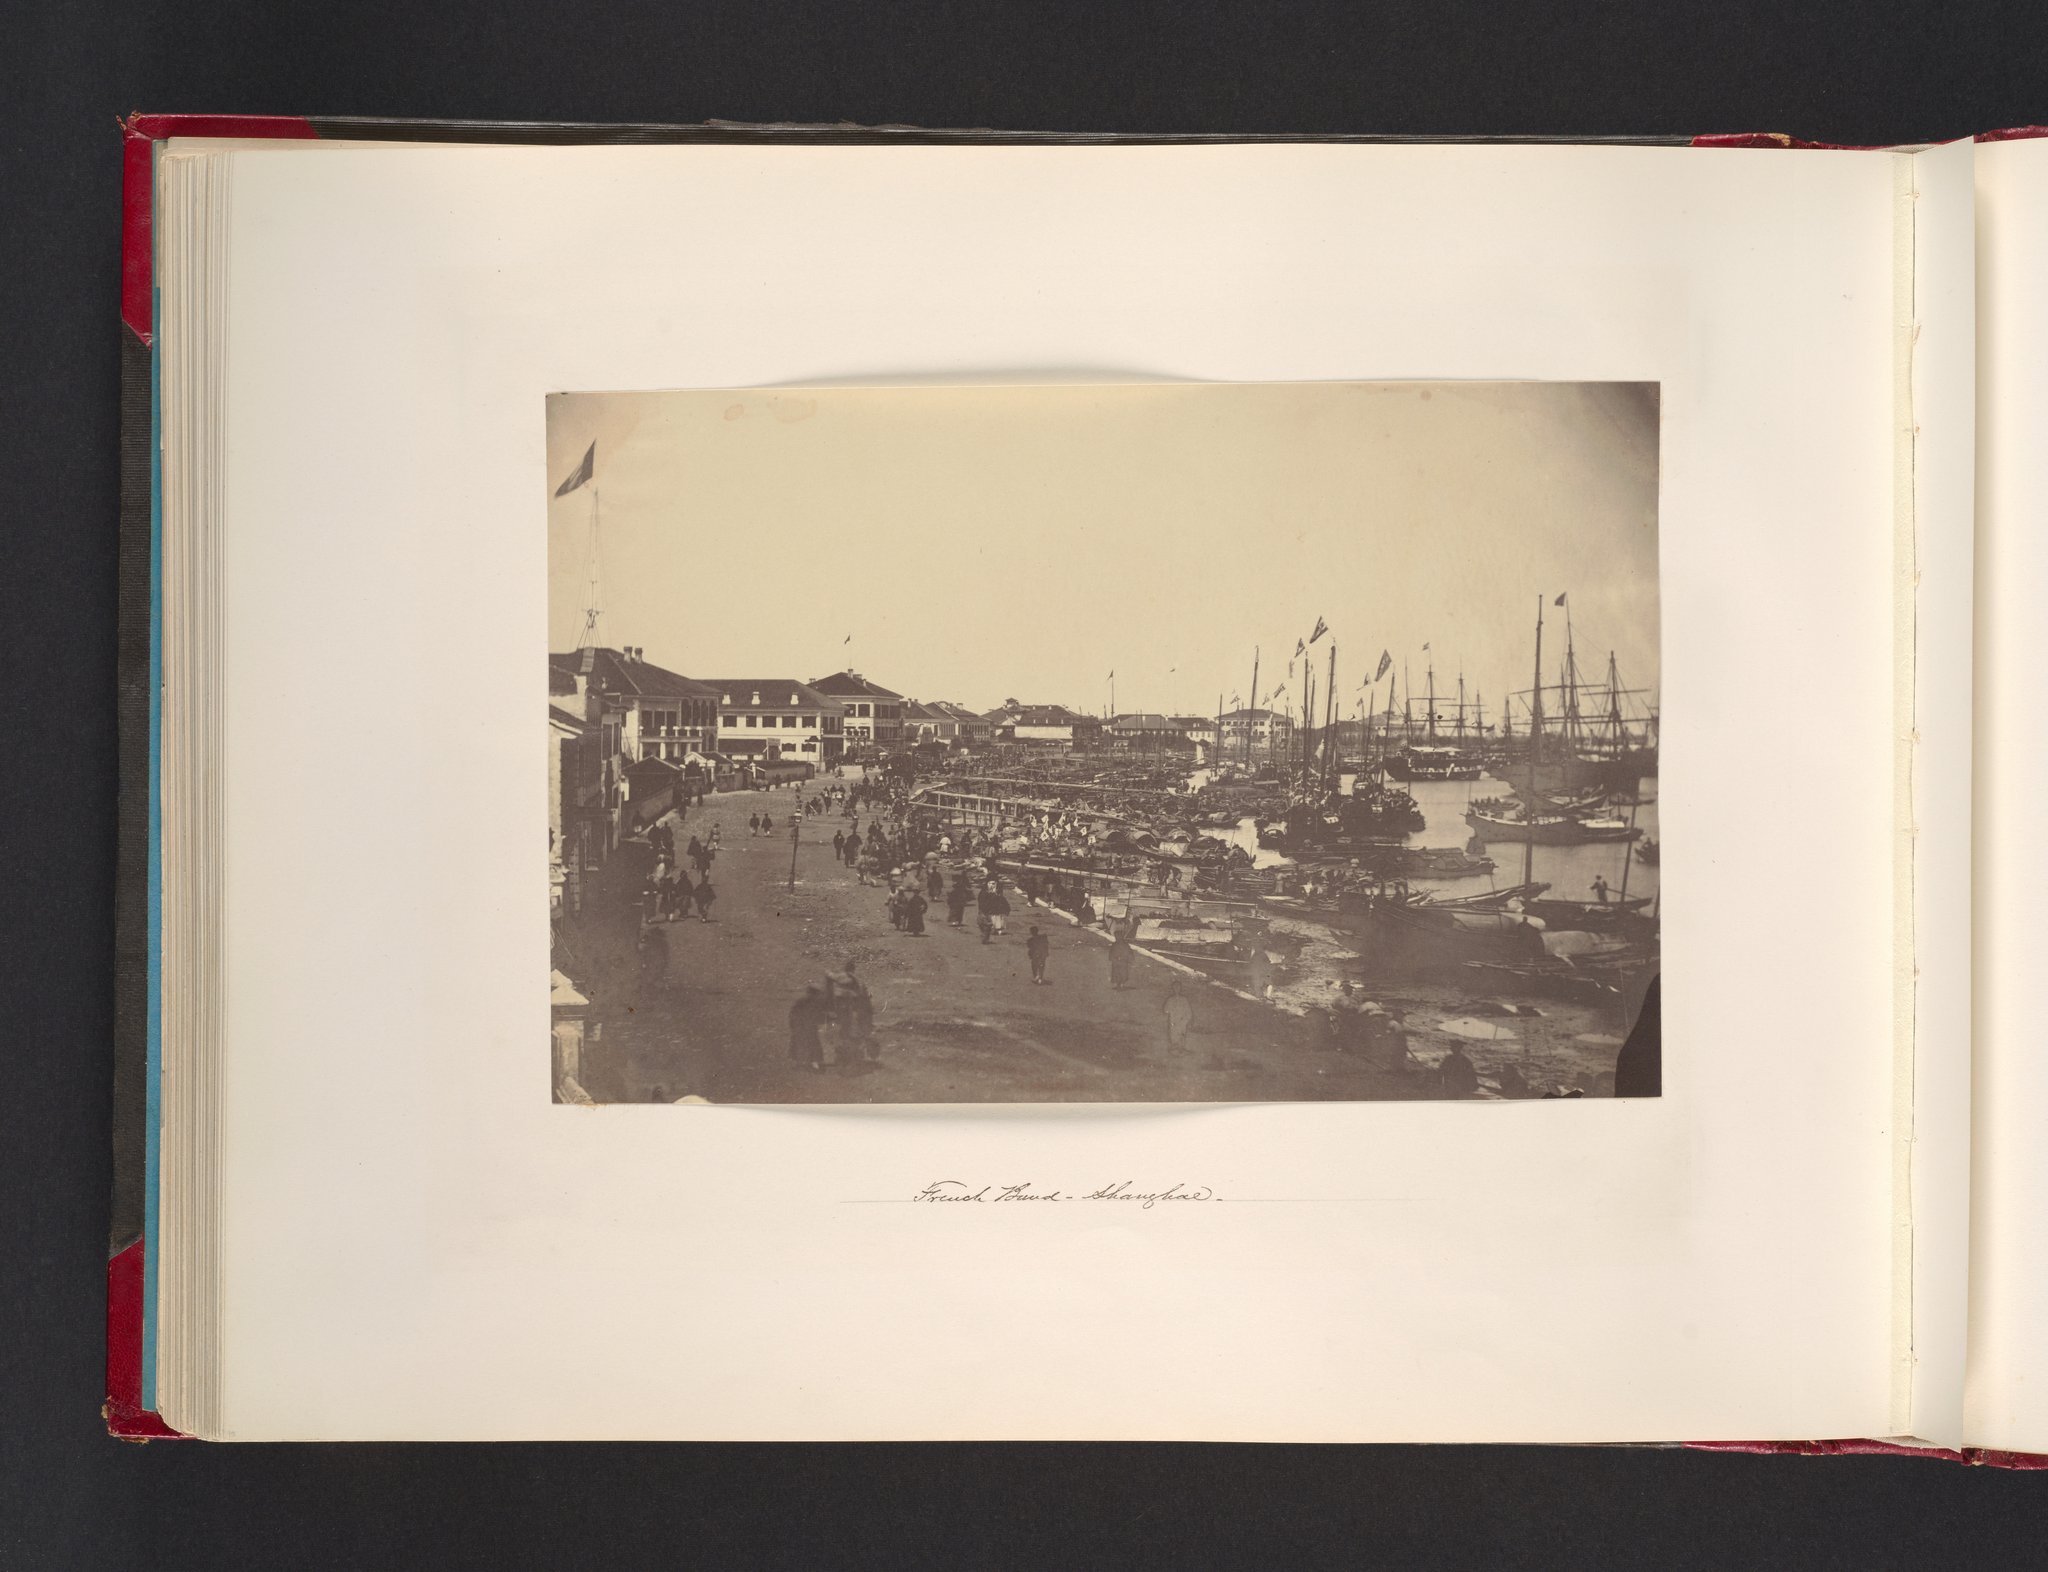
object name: photograph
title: French Bund, Shanghai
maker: john thomson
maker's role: artist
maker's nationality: british, scottish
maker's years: 1837-1921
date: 1865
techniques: albumen silver print, glass negative